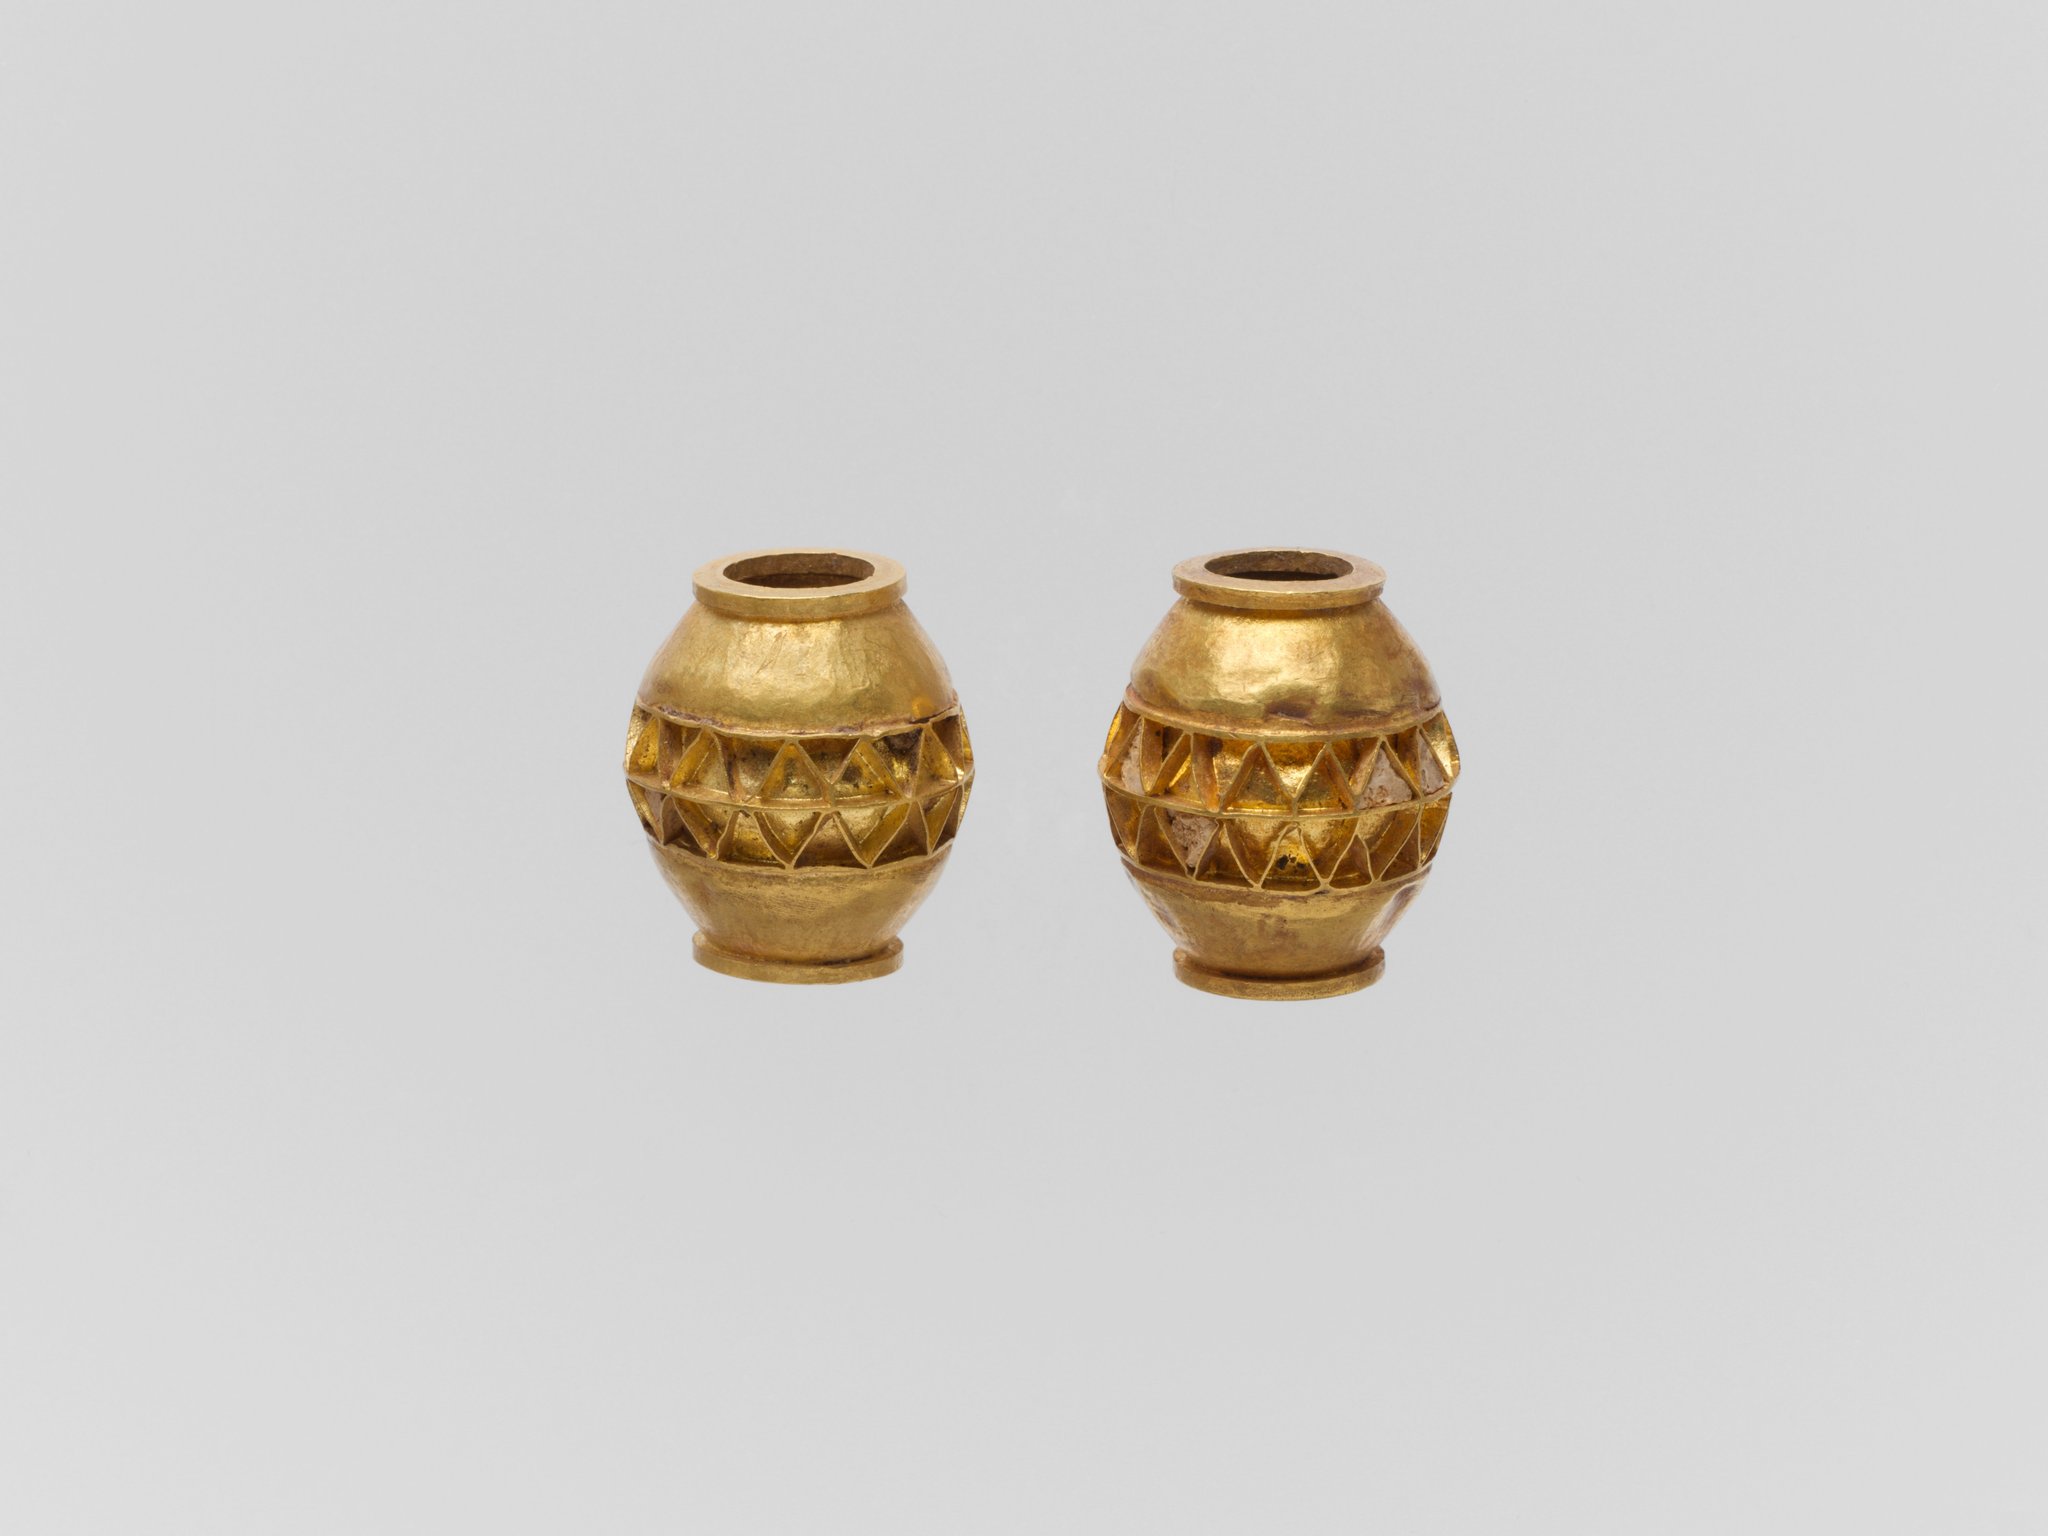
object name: bead, control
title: Two gold beads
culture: greek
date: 400-201 BCE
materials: gold